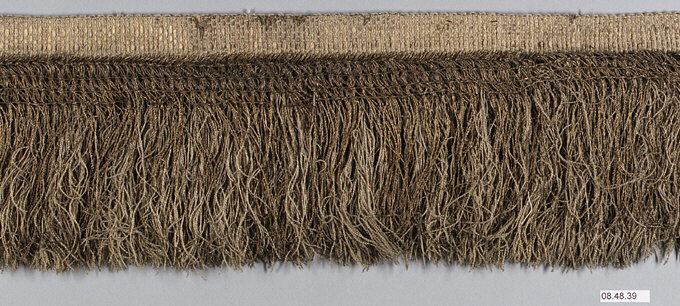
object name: fringe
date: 1650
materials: metal thread, silk